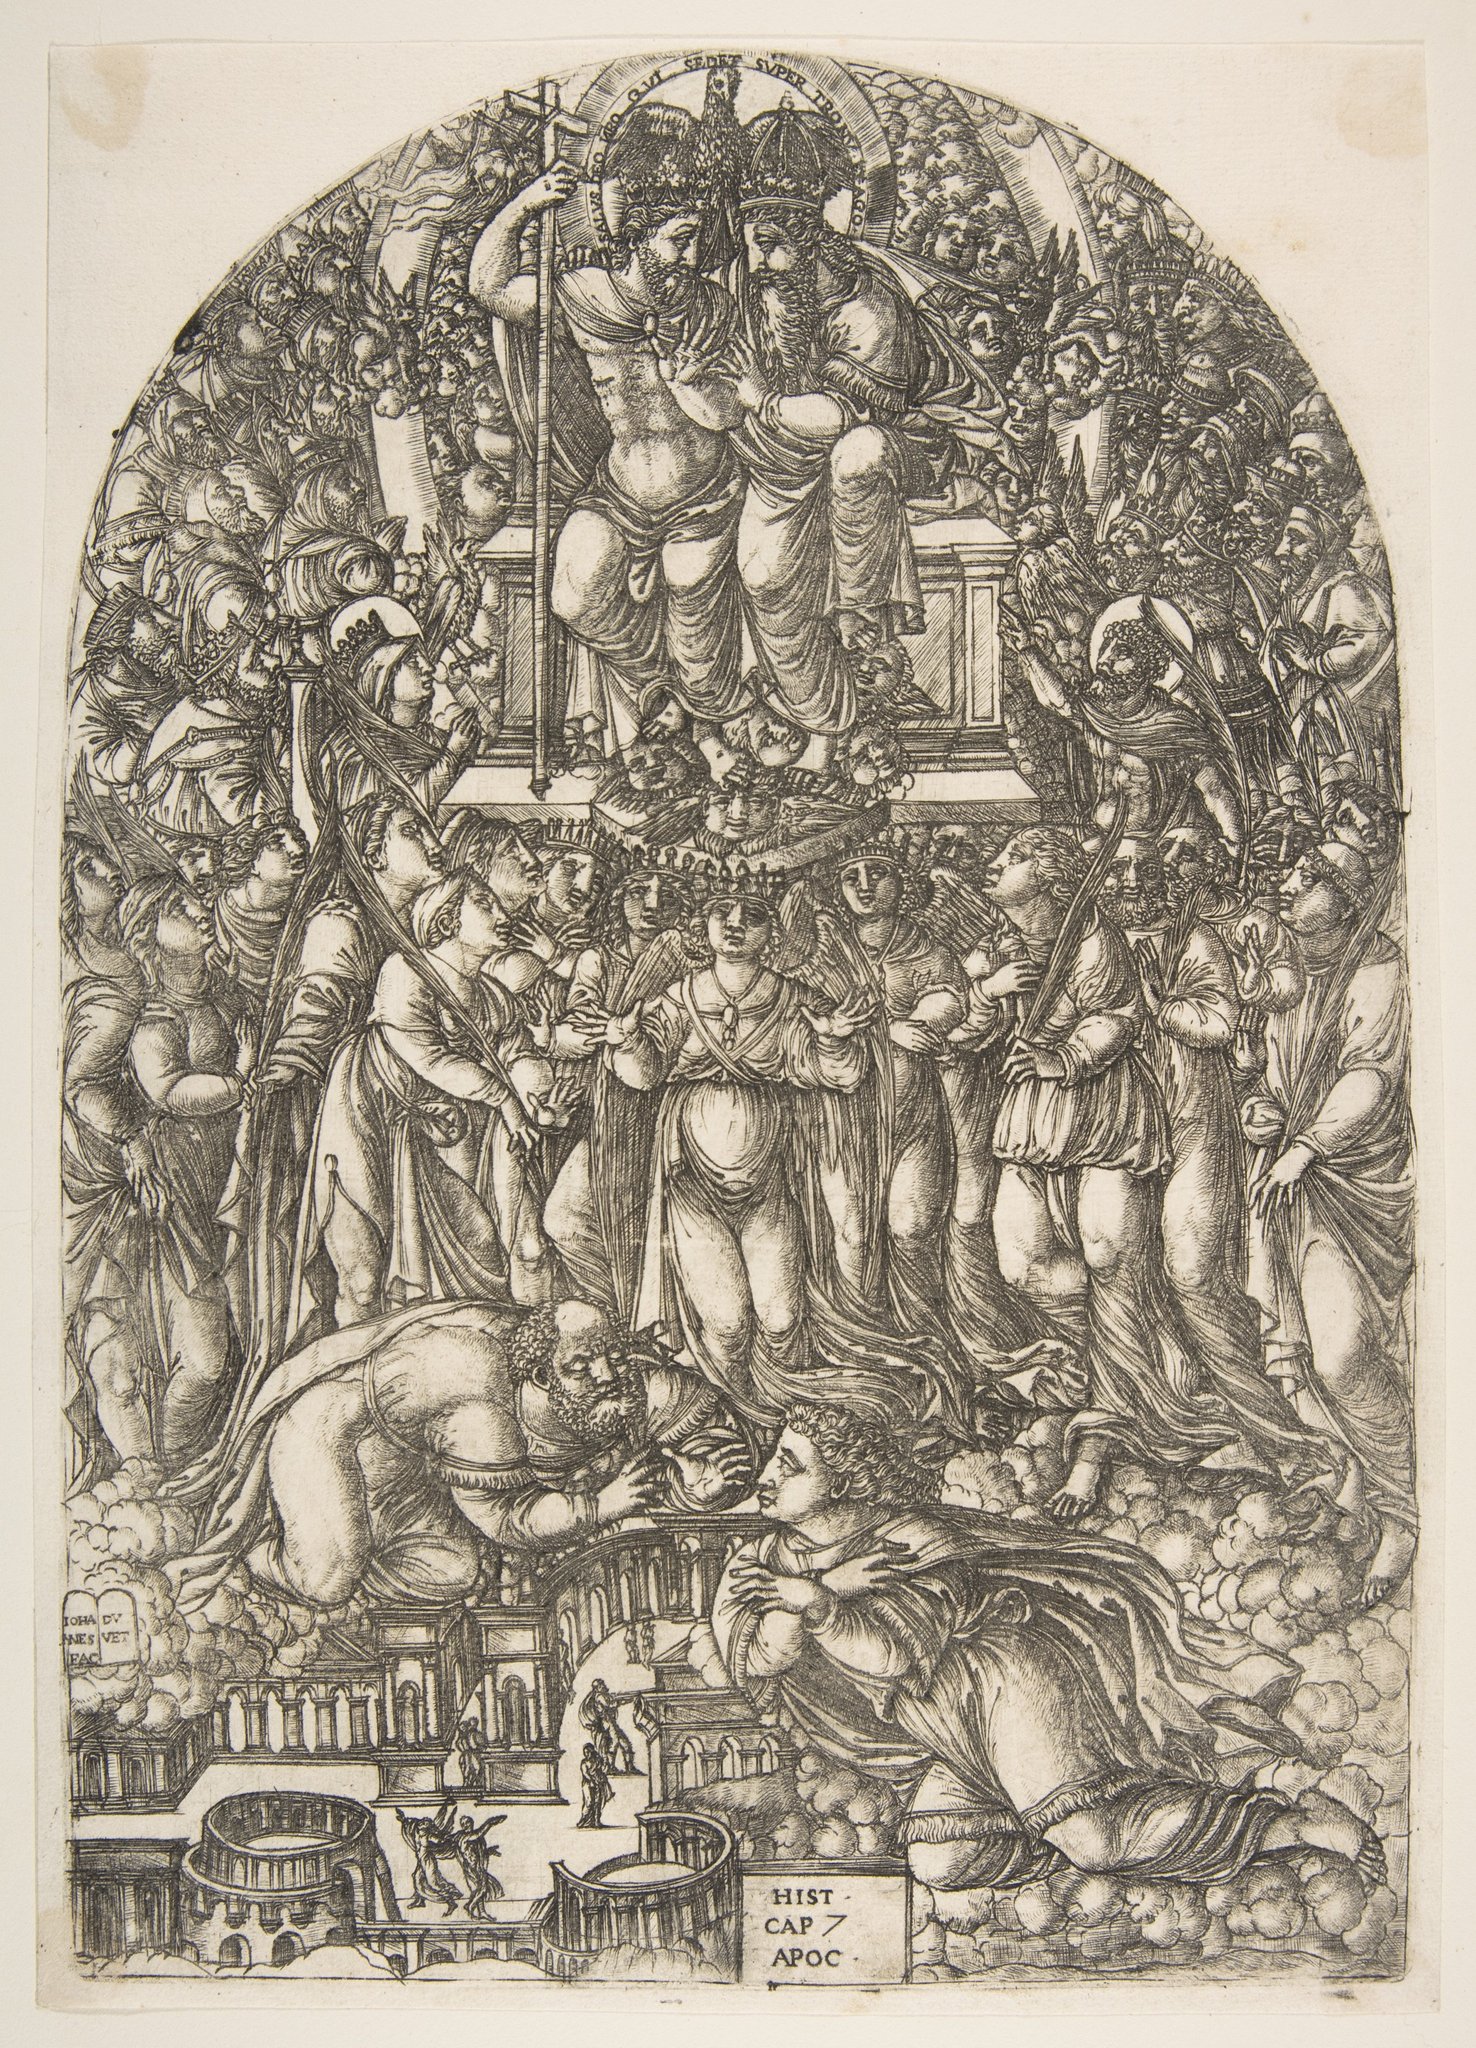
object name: print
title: An innumerable Multitude which Stands before the Throne, from the Apocalypse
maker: jean duvet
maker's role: artist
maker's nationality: french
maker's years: 1485-1561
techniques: engraving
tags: apocalypse